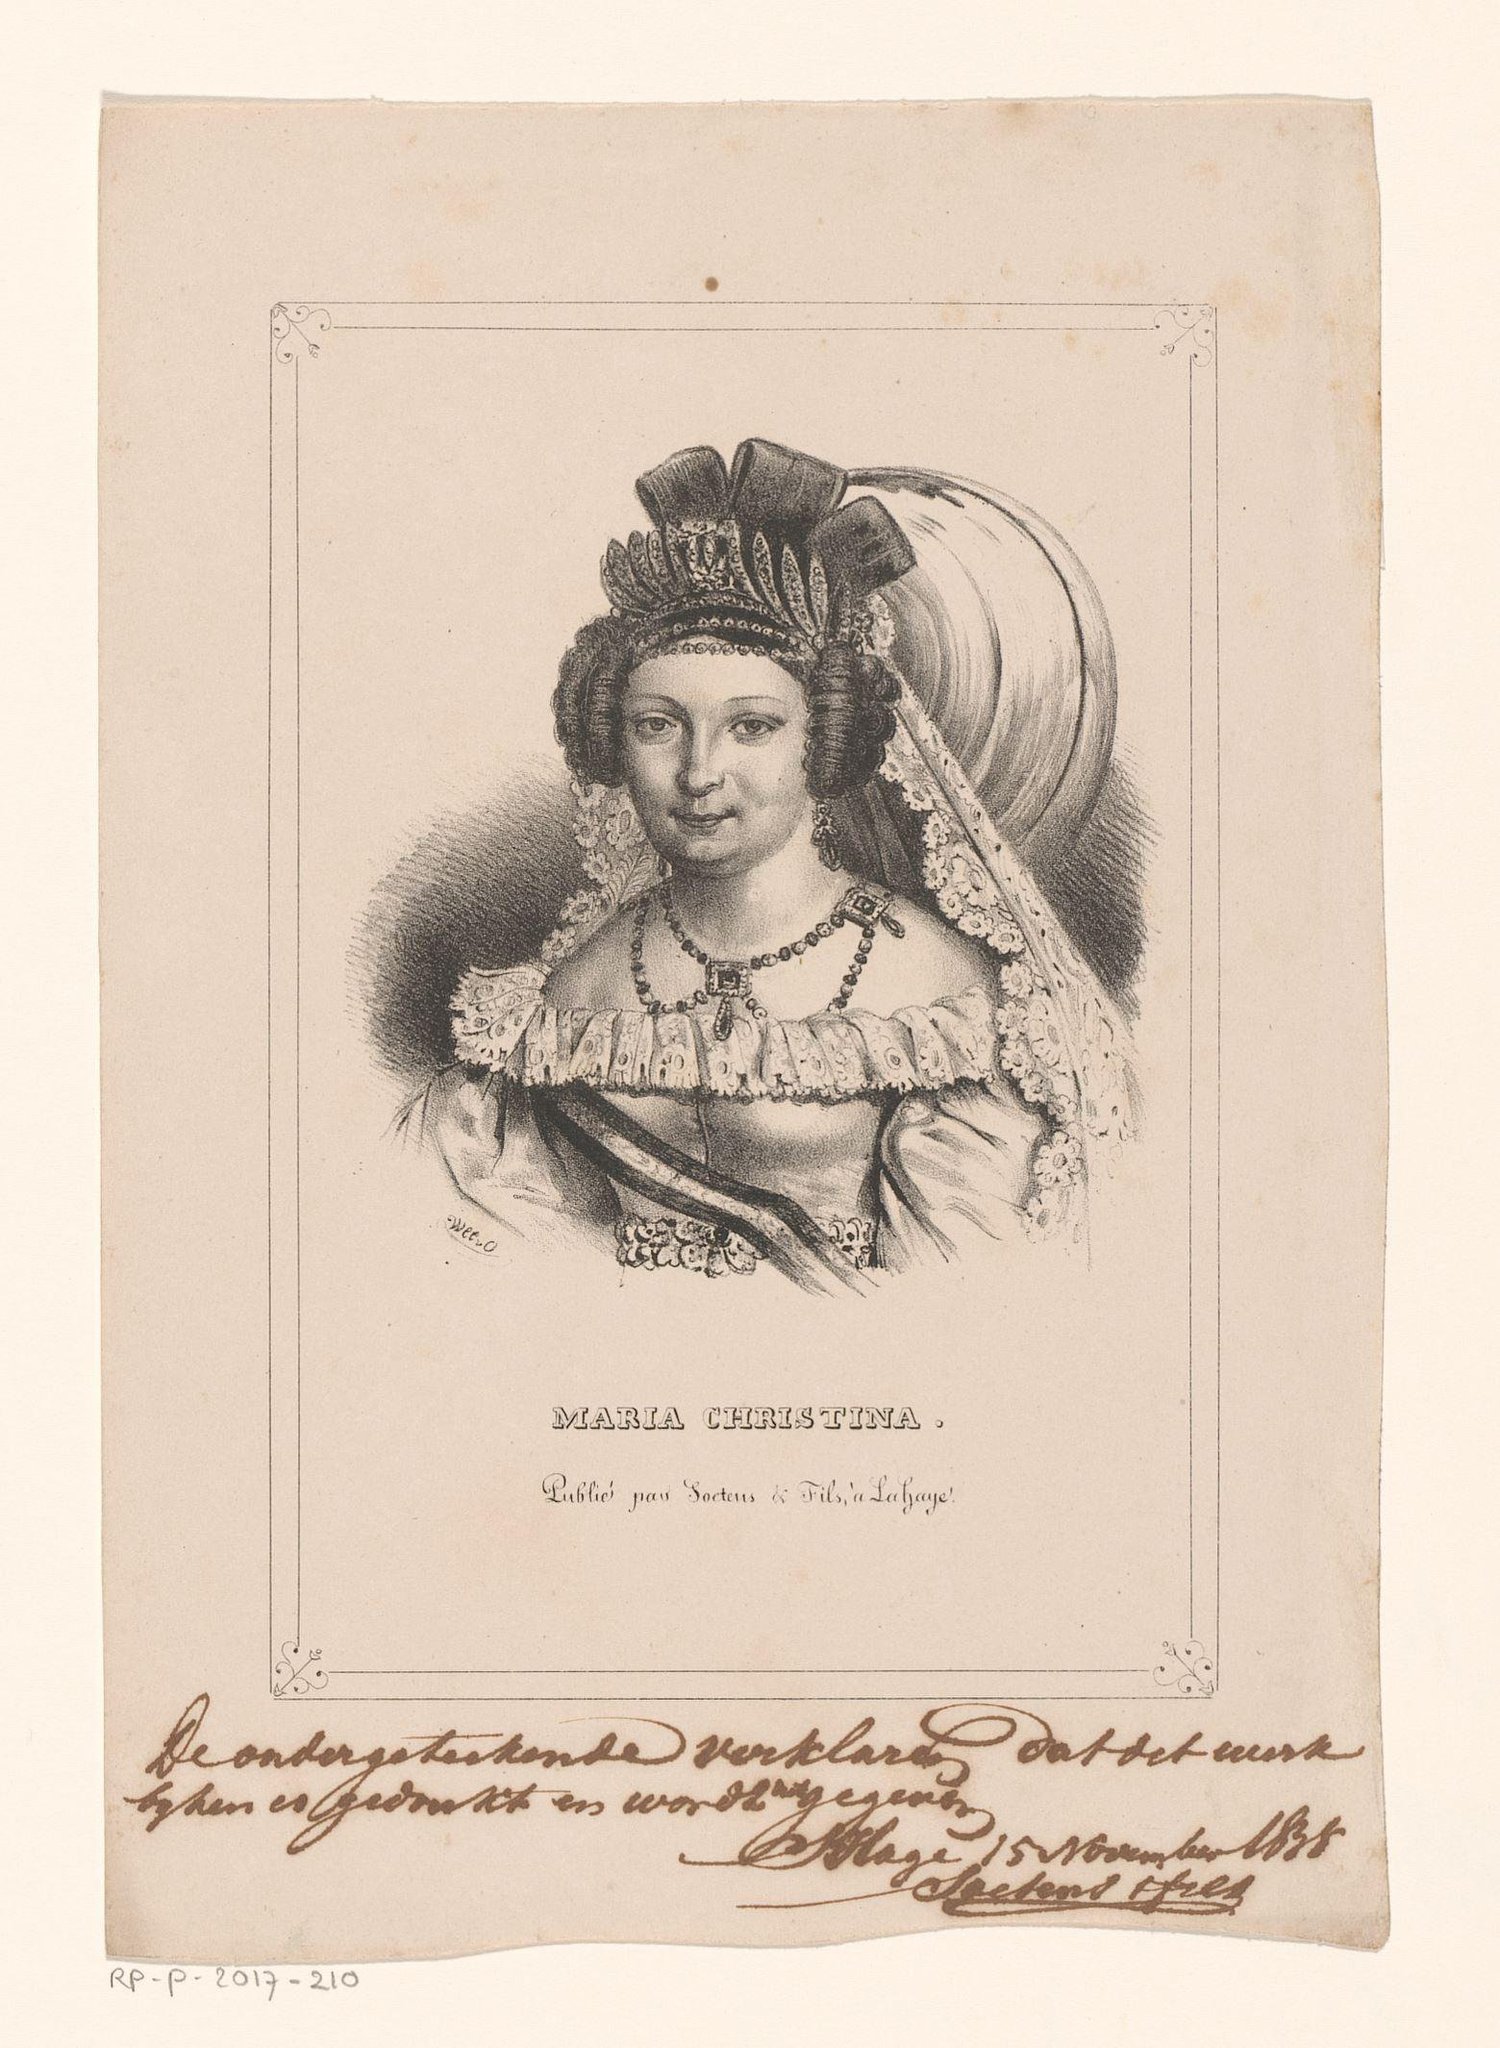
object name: print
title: Portret van Maria Christina van Bourbon-Sicilië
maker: wilhelmus cornelis chimaer van oudendorp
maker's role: print maker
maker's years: 1822-1873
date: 1837-1840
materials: paper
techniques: lithograph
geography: the hague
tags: le havre, historical persons - bb - woman (+ (full) bust portrait)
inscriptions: : ‘De ondergeteekende verklaren dat dit werk / bij hen is gedrukt en wordt uitgegeven / s Hage 15 november 1838 / Soetens&Fils’